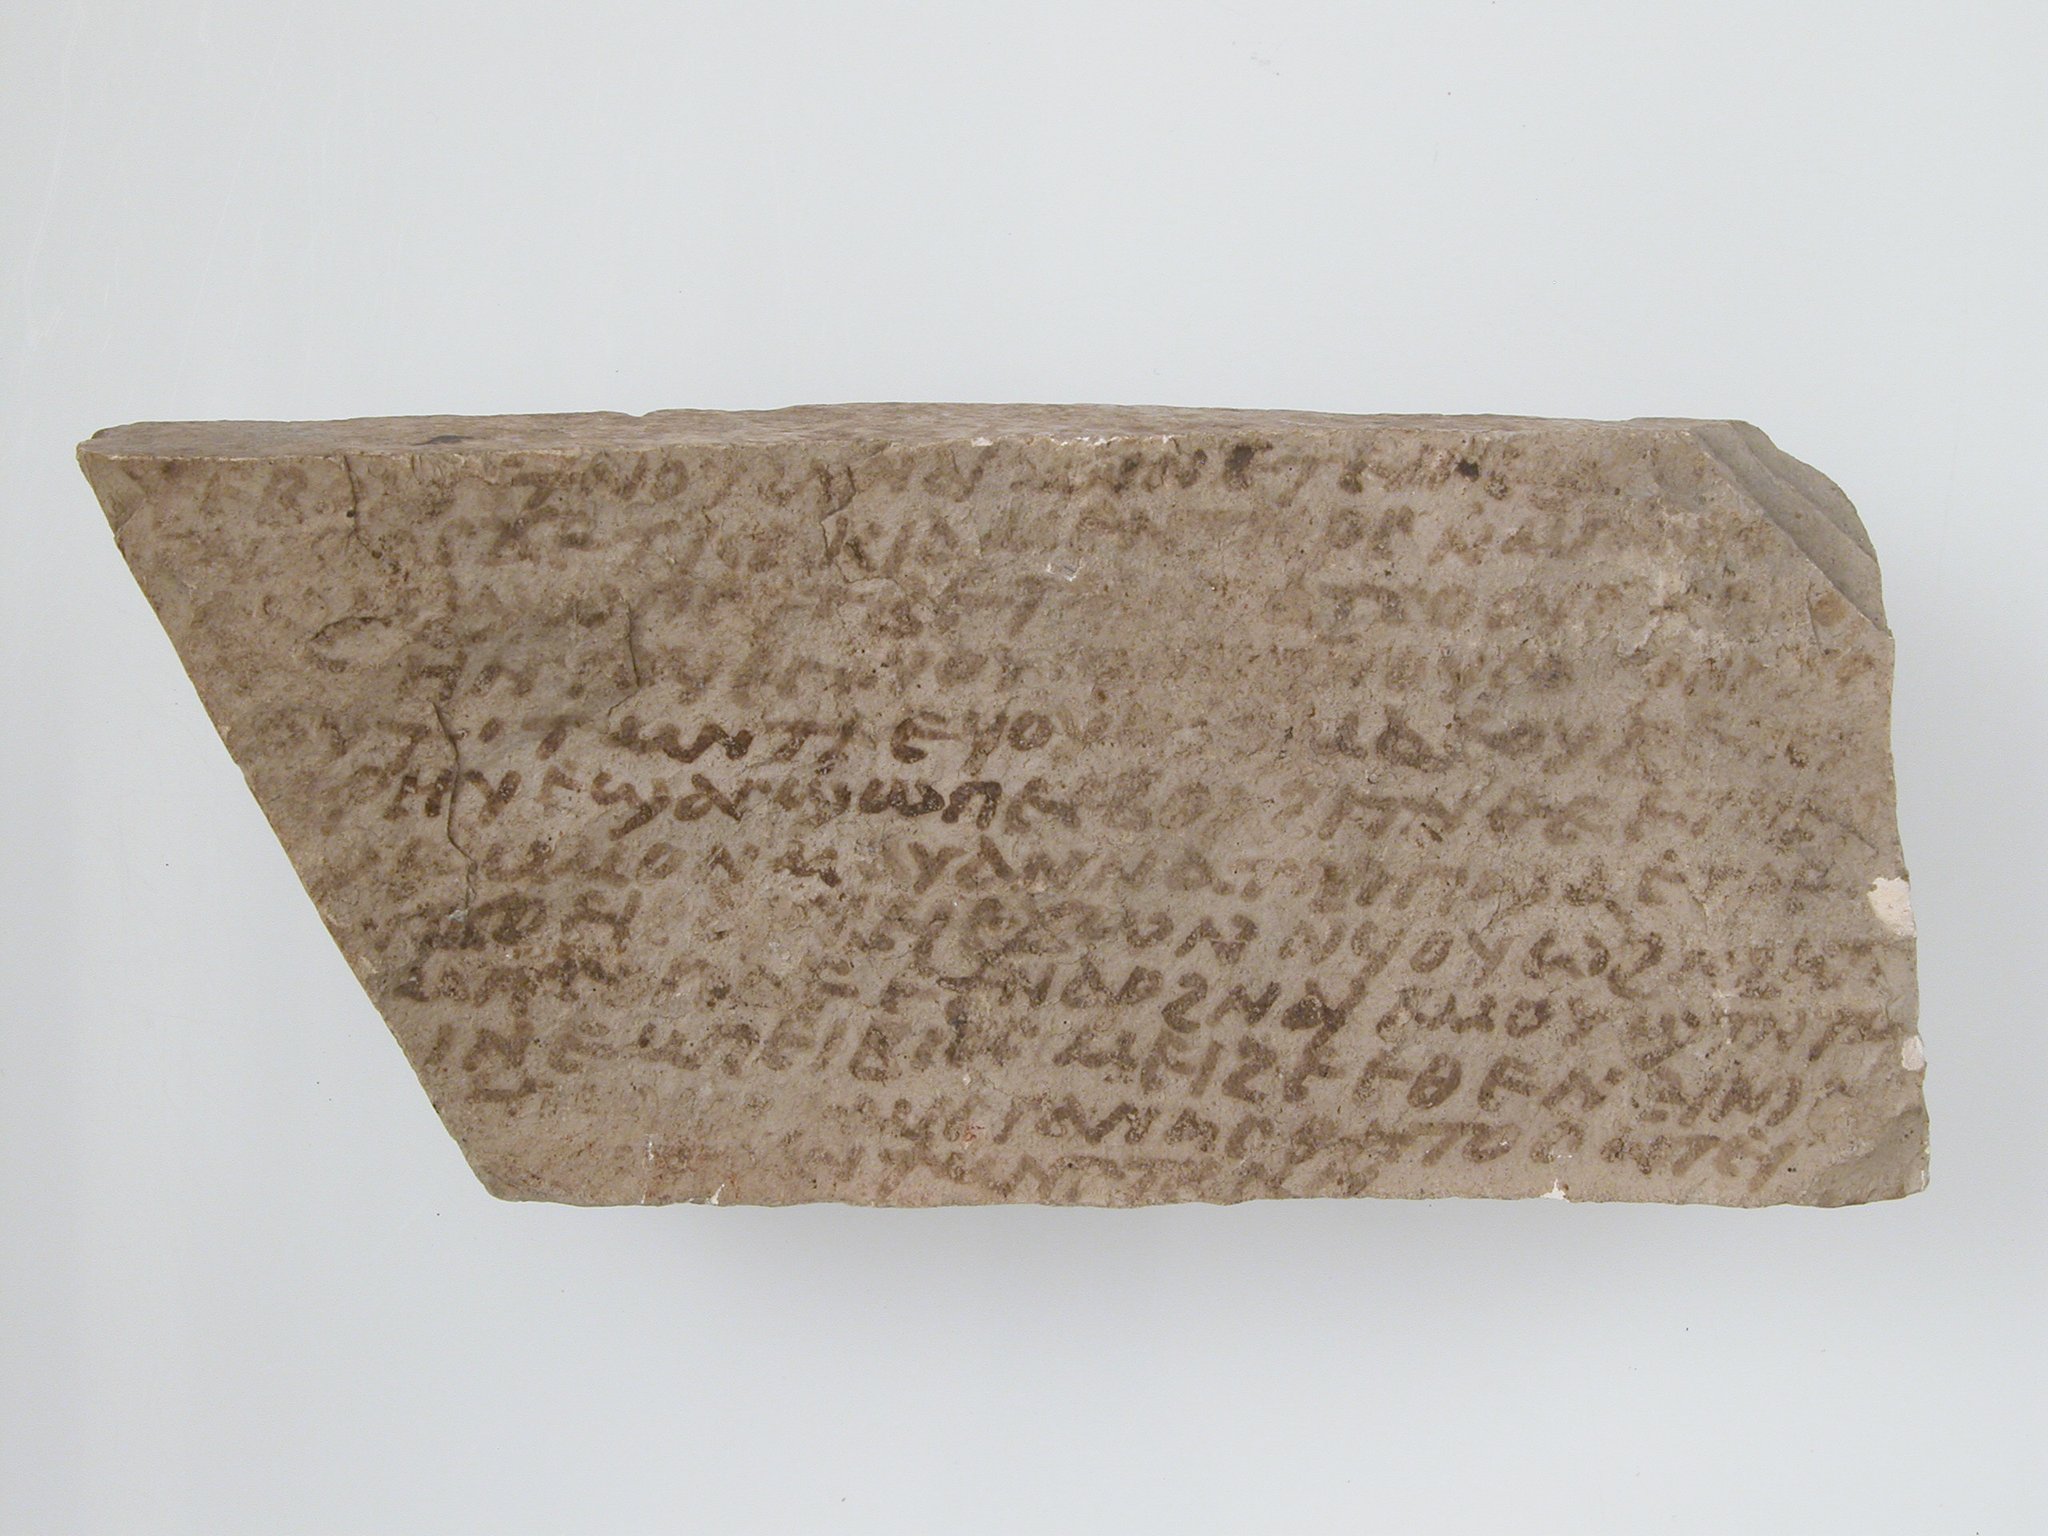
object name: ostrakon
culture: coptic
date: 601-700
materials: ink, limestone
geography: egypt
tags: documents